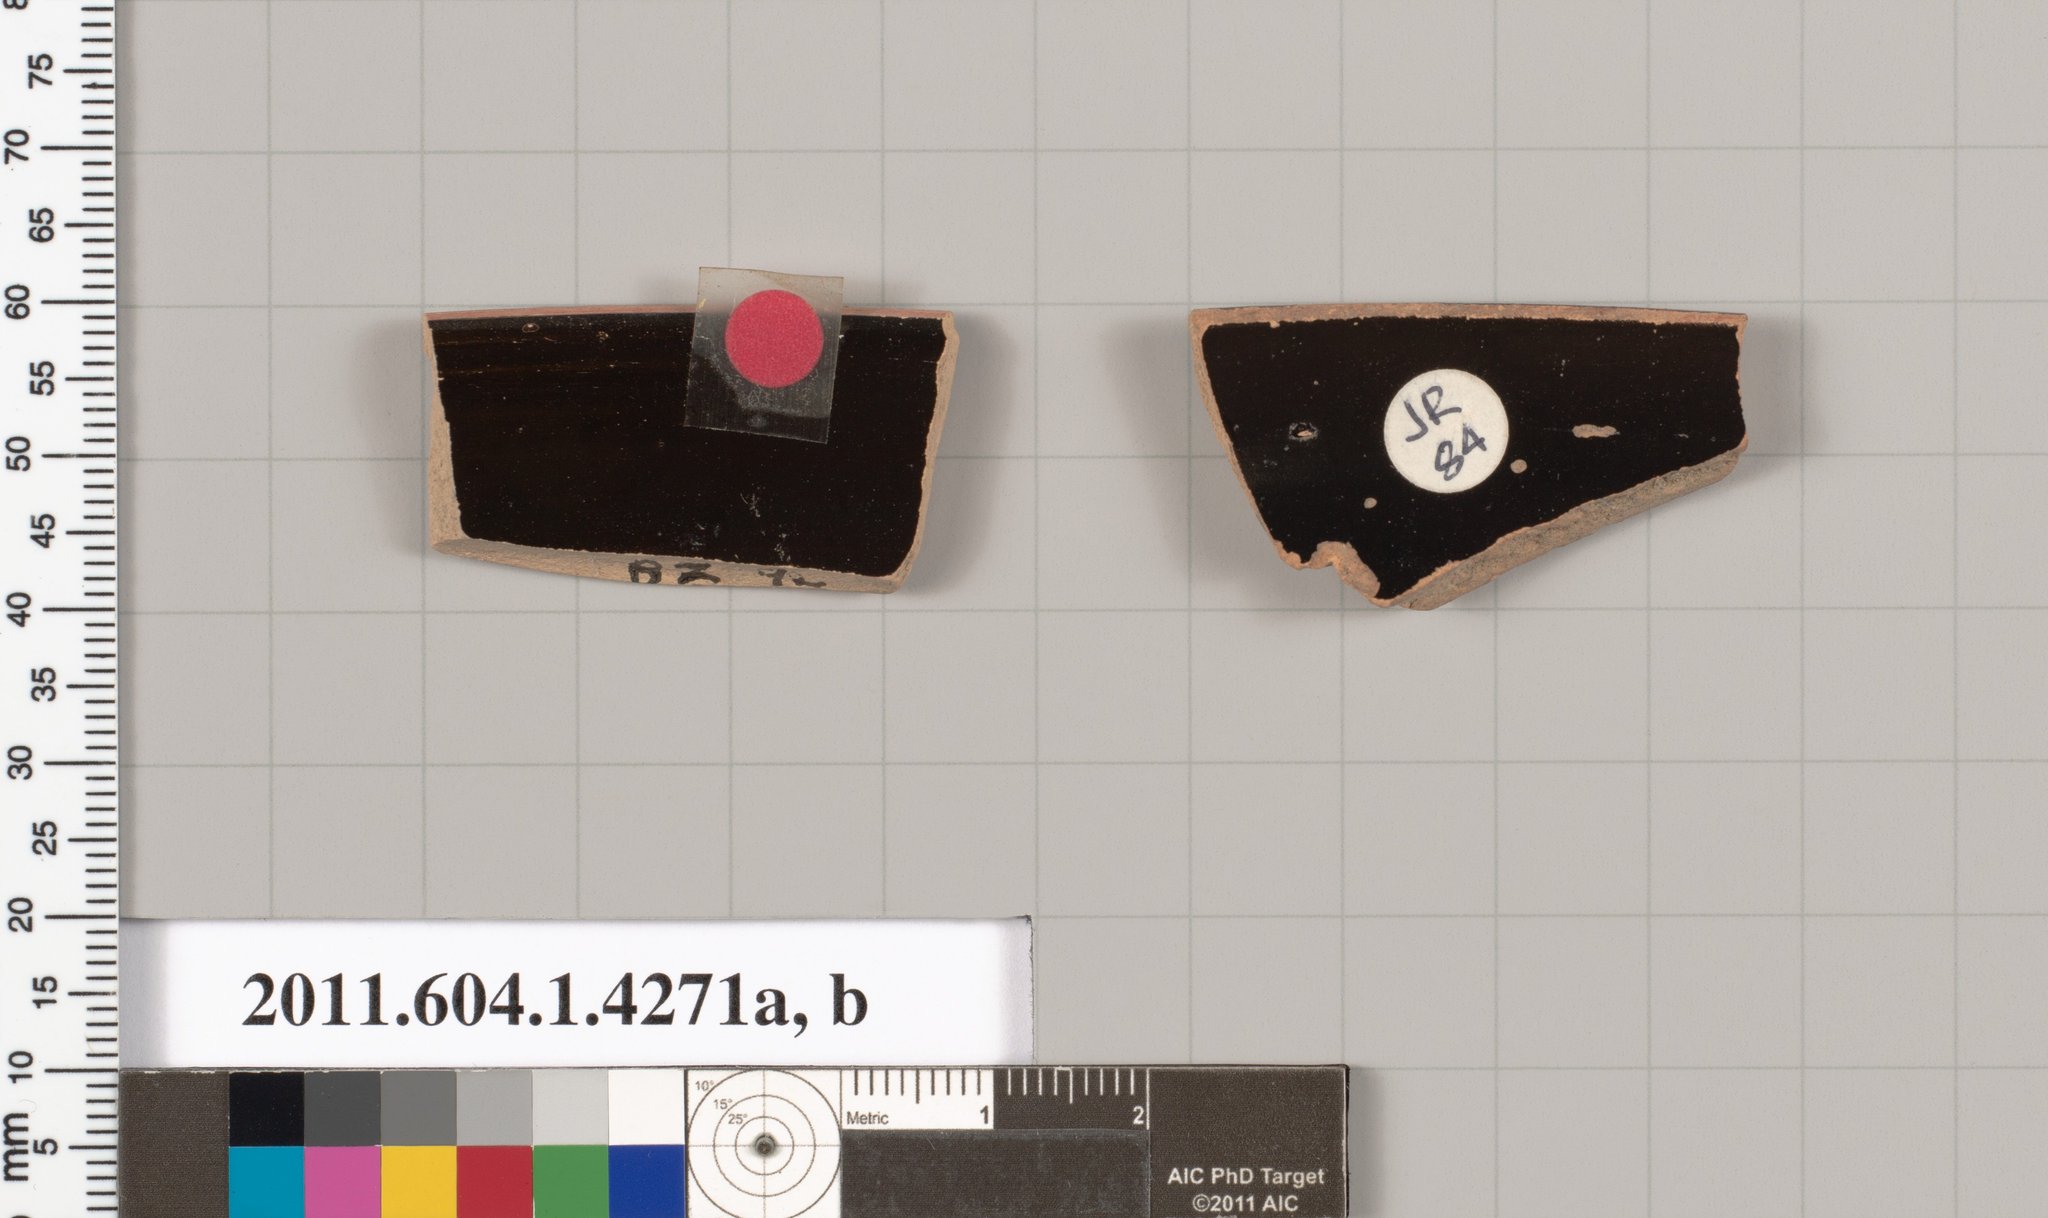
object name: kylix fragment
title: Terracotta rim fragments of kylikes (drinking cups)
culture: greek, attic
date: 520-500 BCE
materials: terracotta